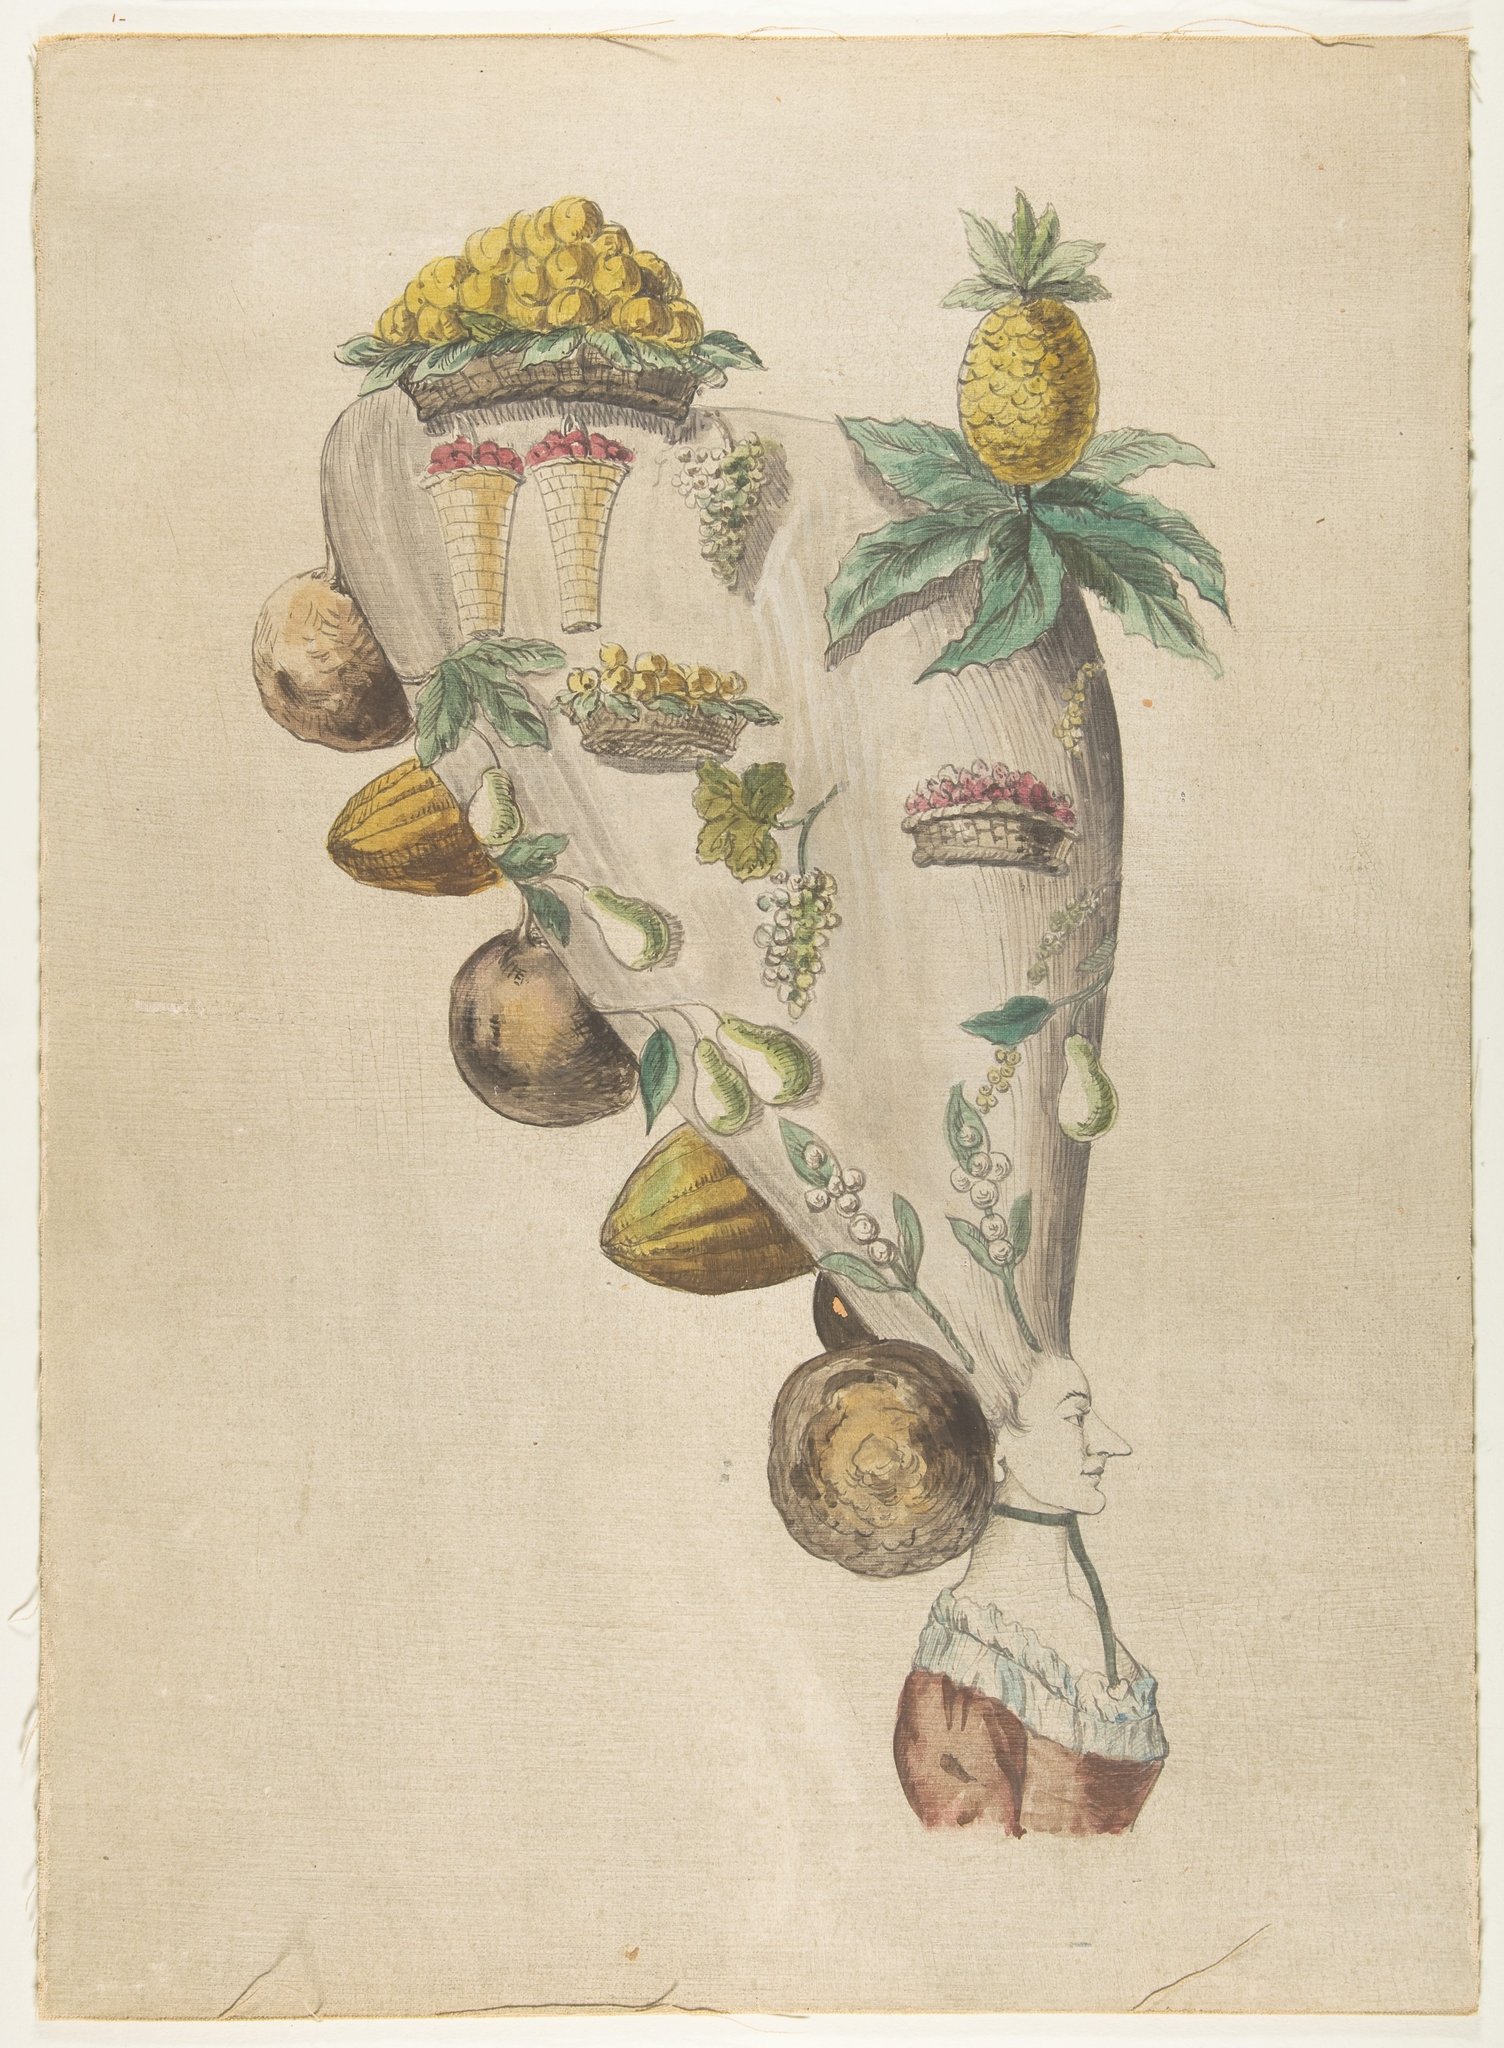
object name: drawing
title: Fantastic Hairdresses with Fruit and Vegetable Motifs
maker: anonymous, french, 18th century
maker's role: artist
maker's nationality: french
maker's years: 1700-1800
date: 1701-1800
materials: board, canvas, watercolor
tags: fruit,vegetables,women